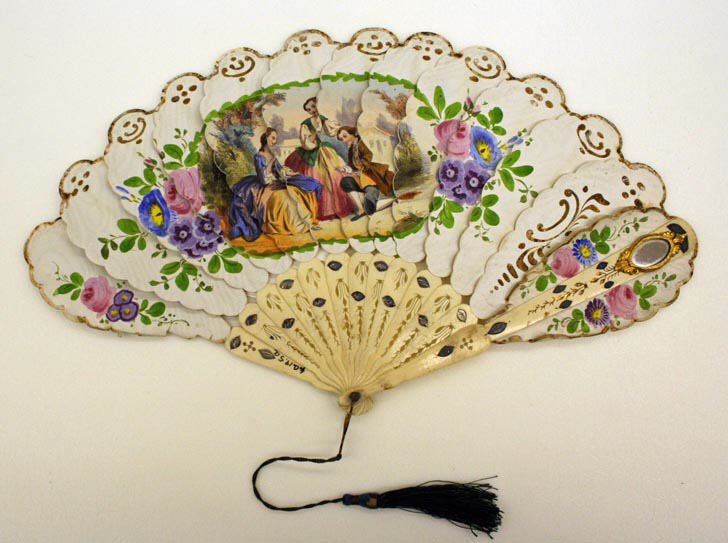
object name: fan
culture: american or european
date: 1860-1869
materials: glass, ivory, metal, paper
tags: men,women